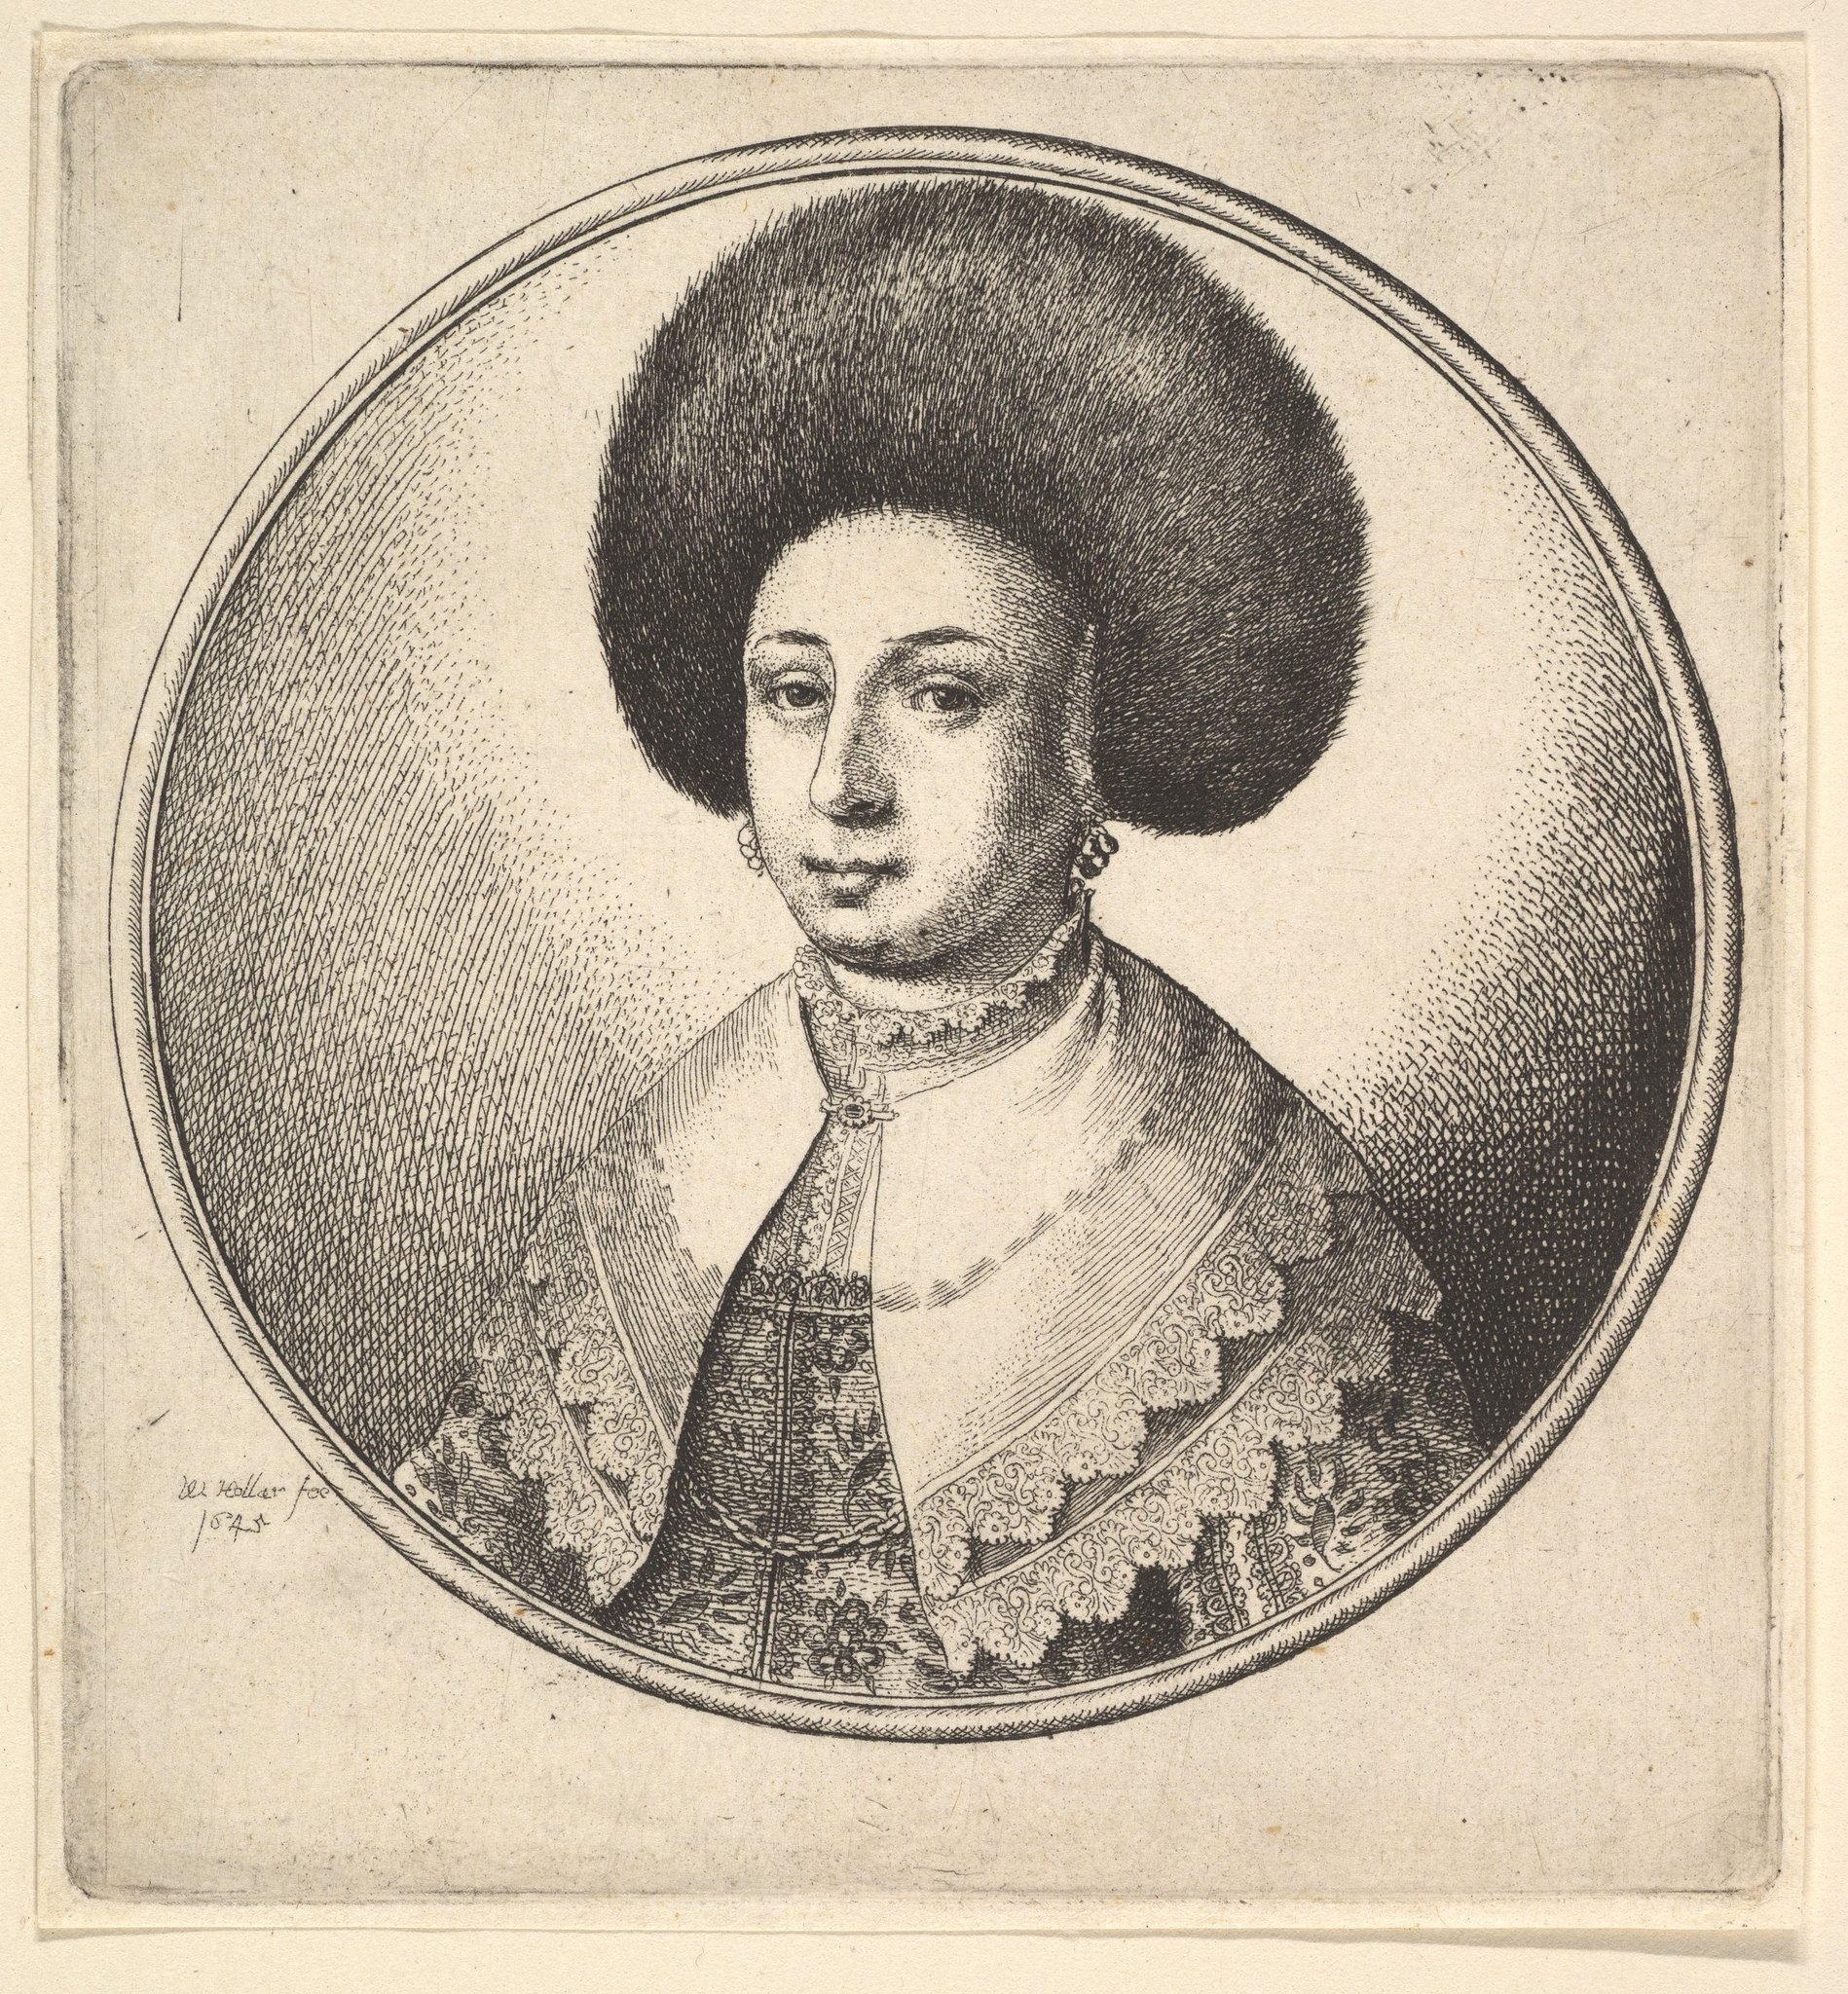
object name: print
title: Woman with large circular fur hat and earrings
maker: wenceslaus hollar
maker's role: artist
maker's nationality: bohemian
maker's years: 1607-1677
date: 1645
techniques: etching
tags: hats,portraits,women